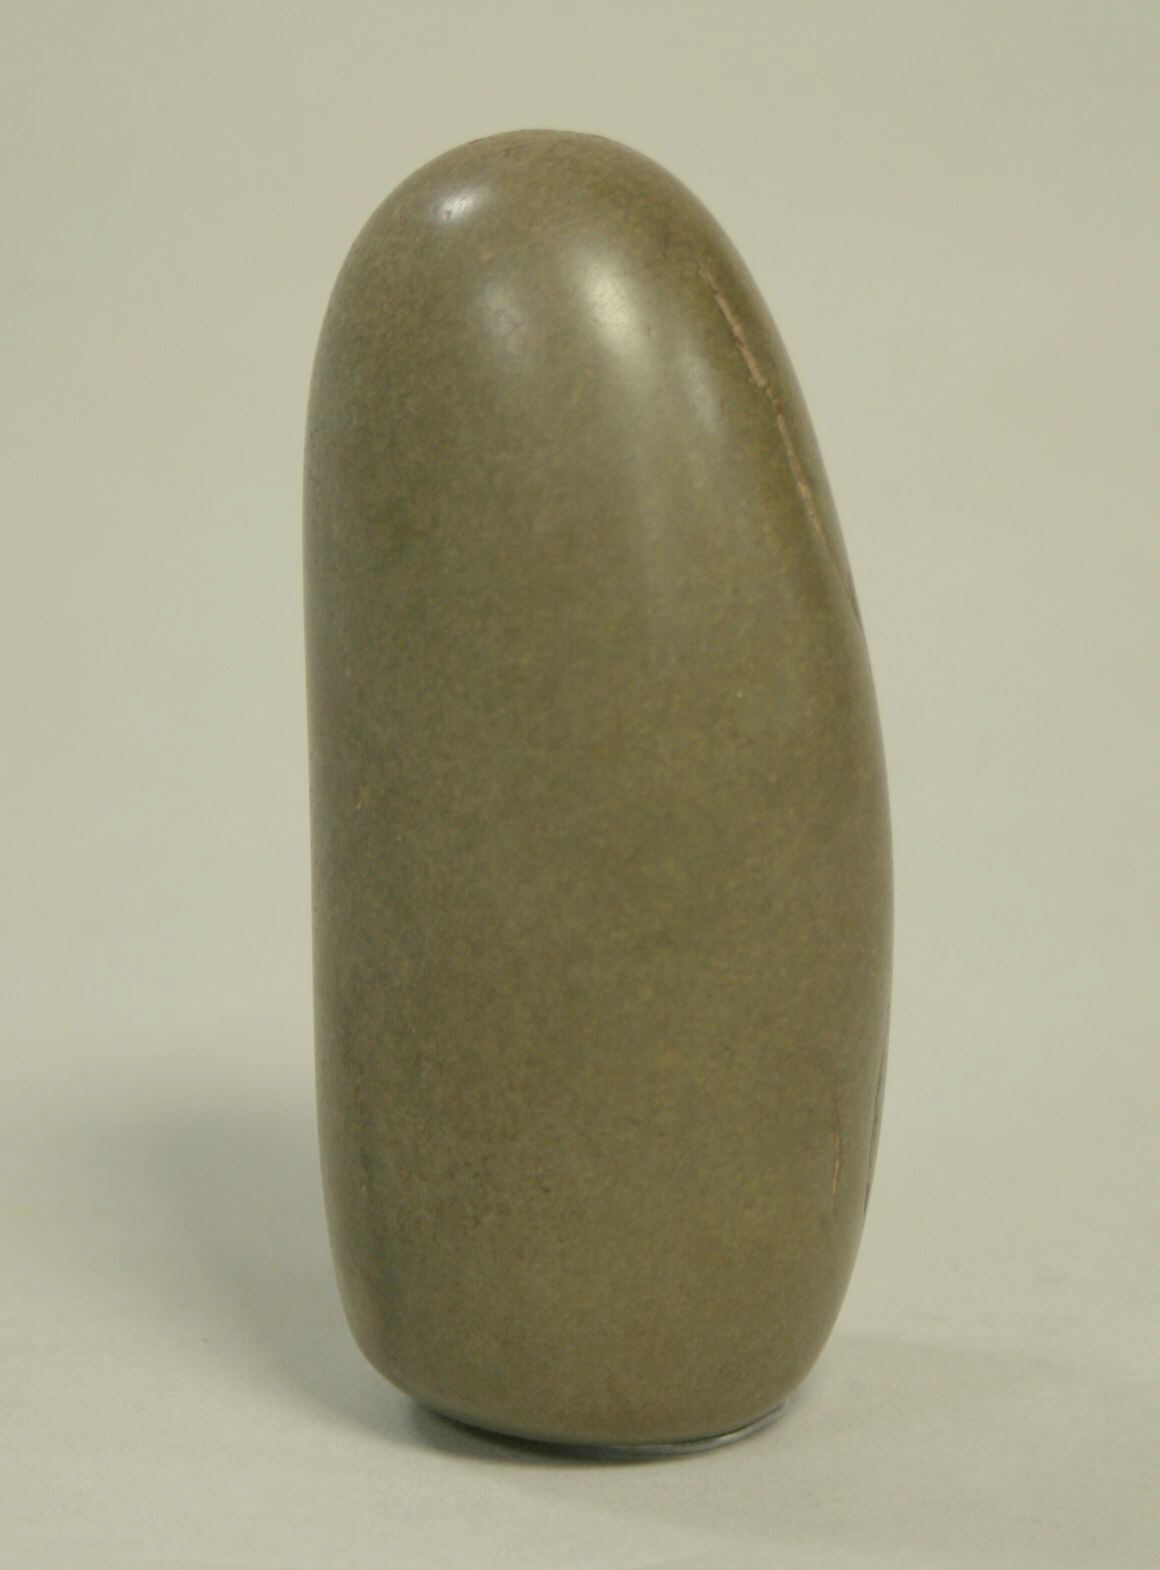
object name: ritual stone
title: Polishing Stone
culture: peruvian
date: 1501-1600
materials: stone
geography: peru